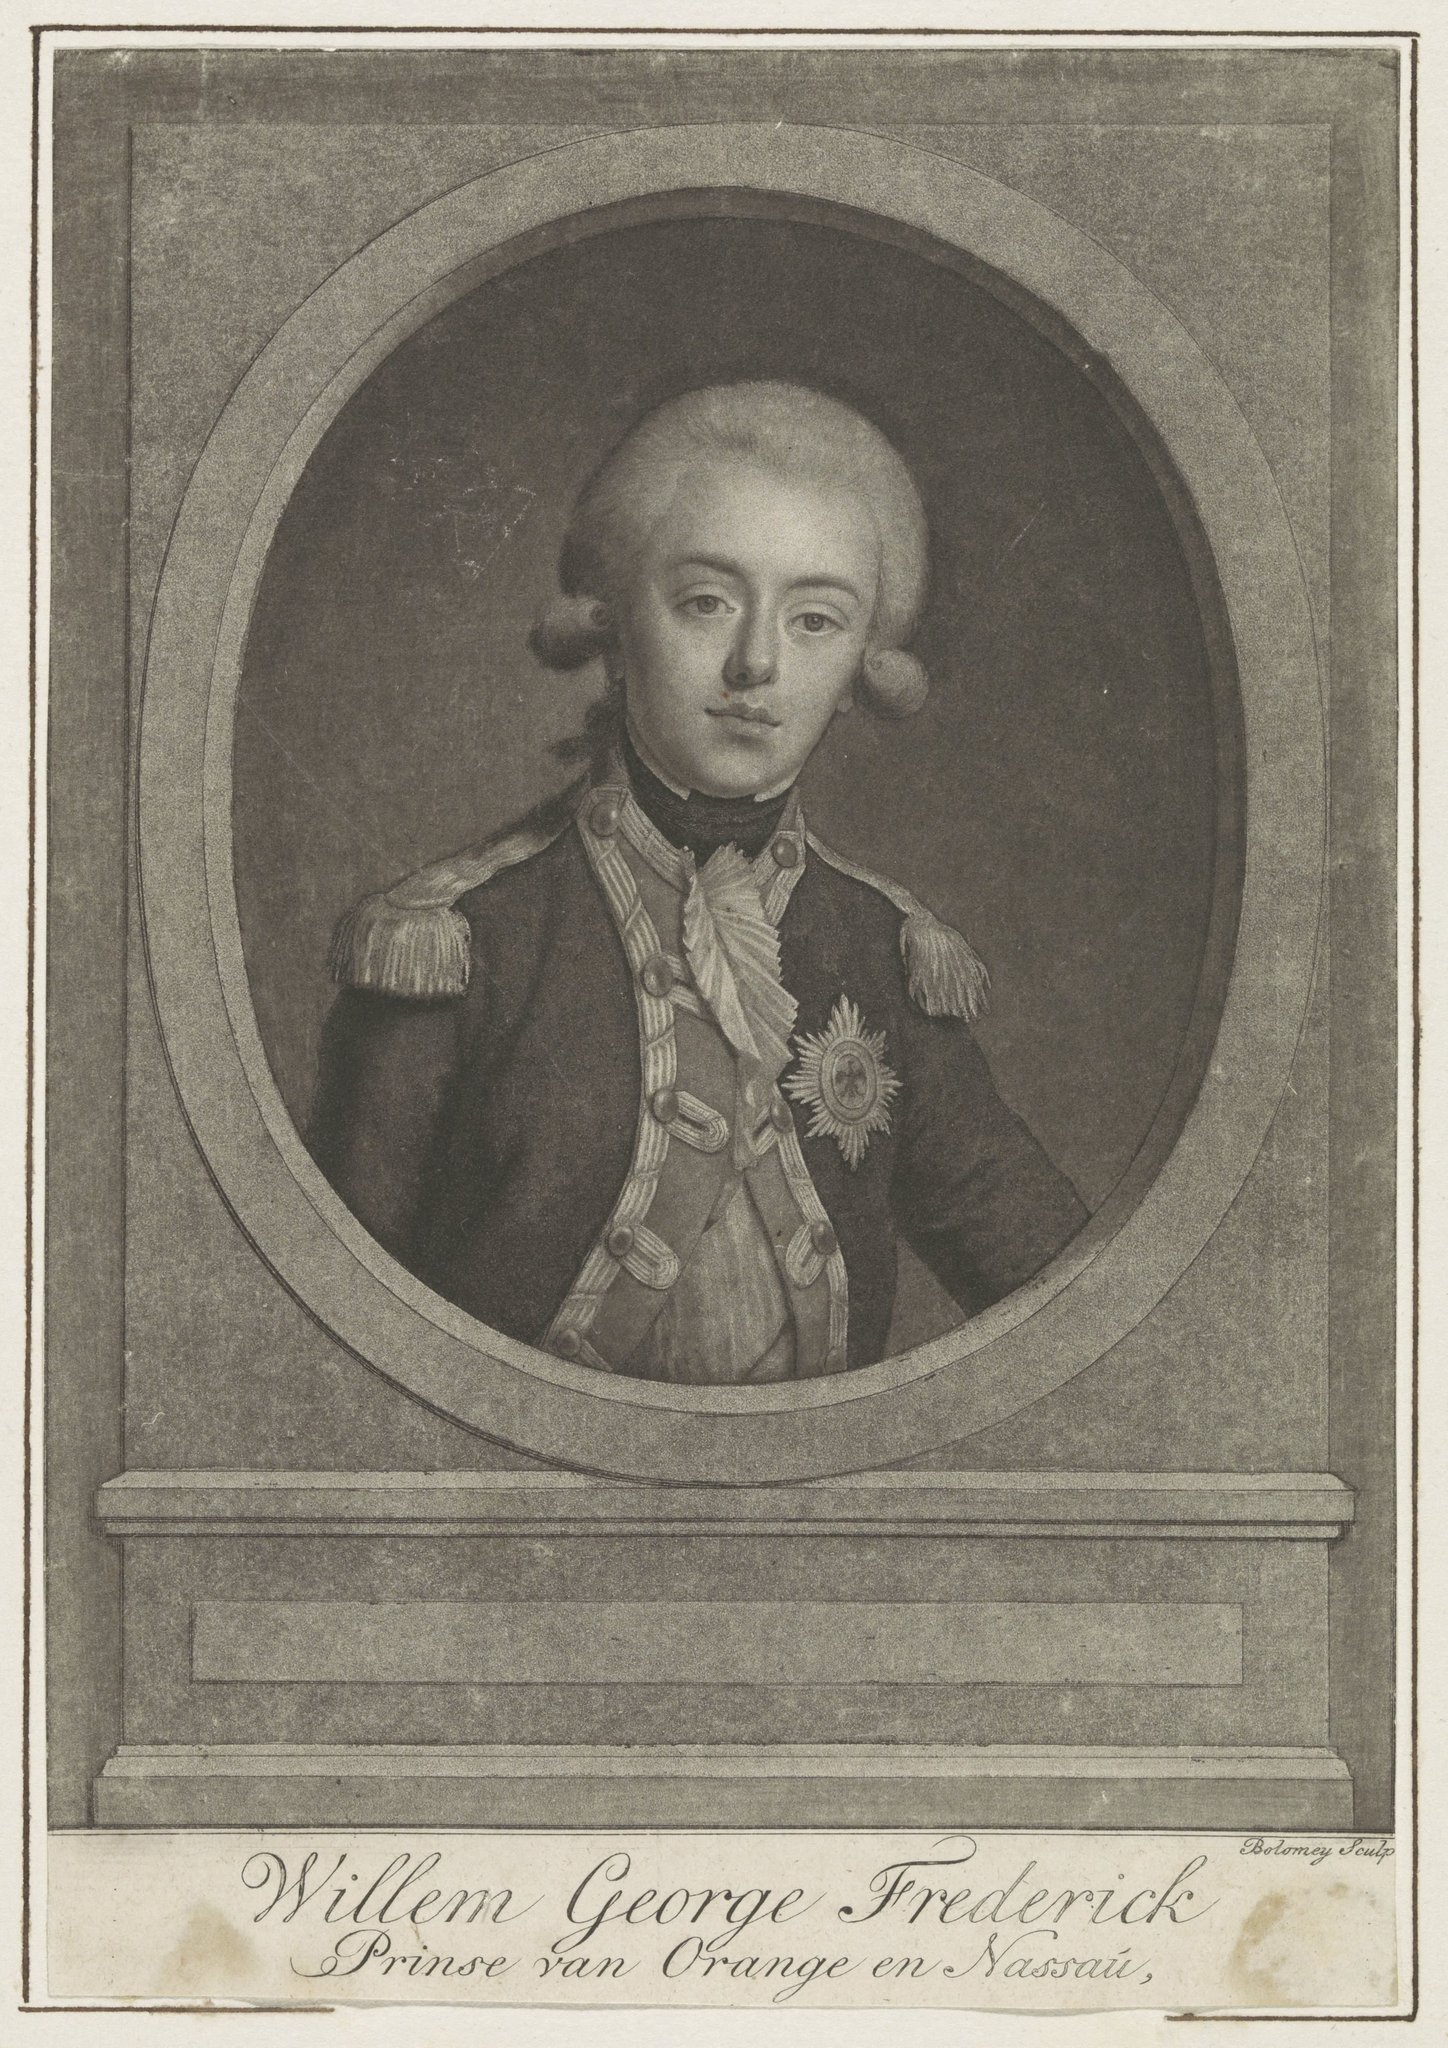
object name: print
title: Portret van Frederik, prins van Oranje-Nassau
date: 1790-1819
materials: paper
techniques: aquatint, etching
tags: the hague, willem george frederik (prins van oranje-nassau), knighthood order (with name) - insignia of a knighthood order, e.g.: badge, chain (with name of order)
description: De hier vermelde titel verwijst naar de hoogst verkregen titel van de geportretteerde, niet per se naar de titel die de geportretteerde op deze voorstelling draagt.